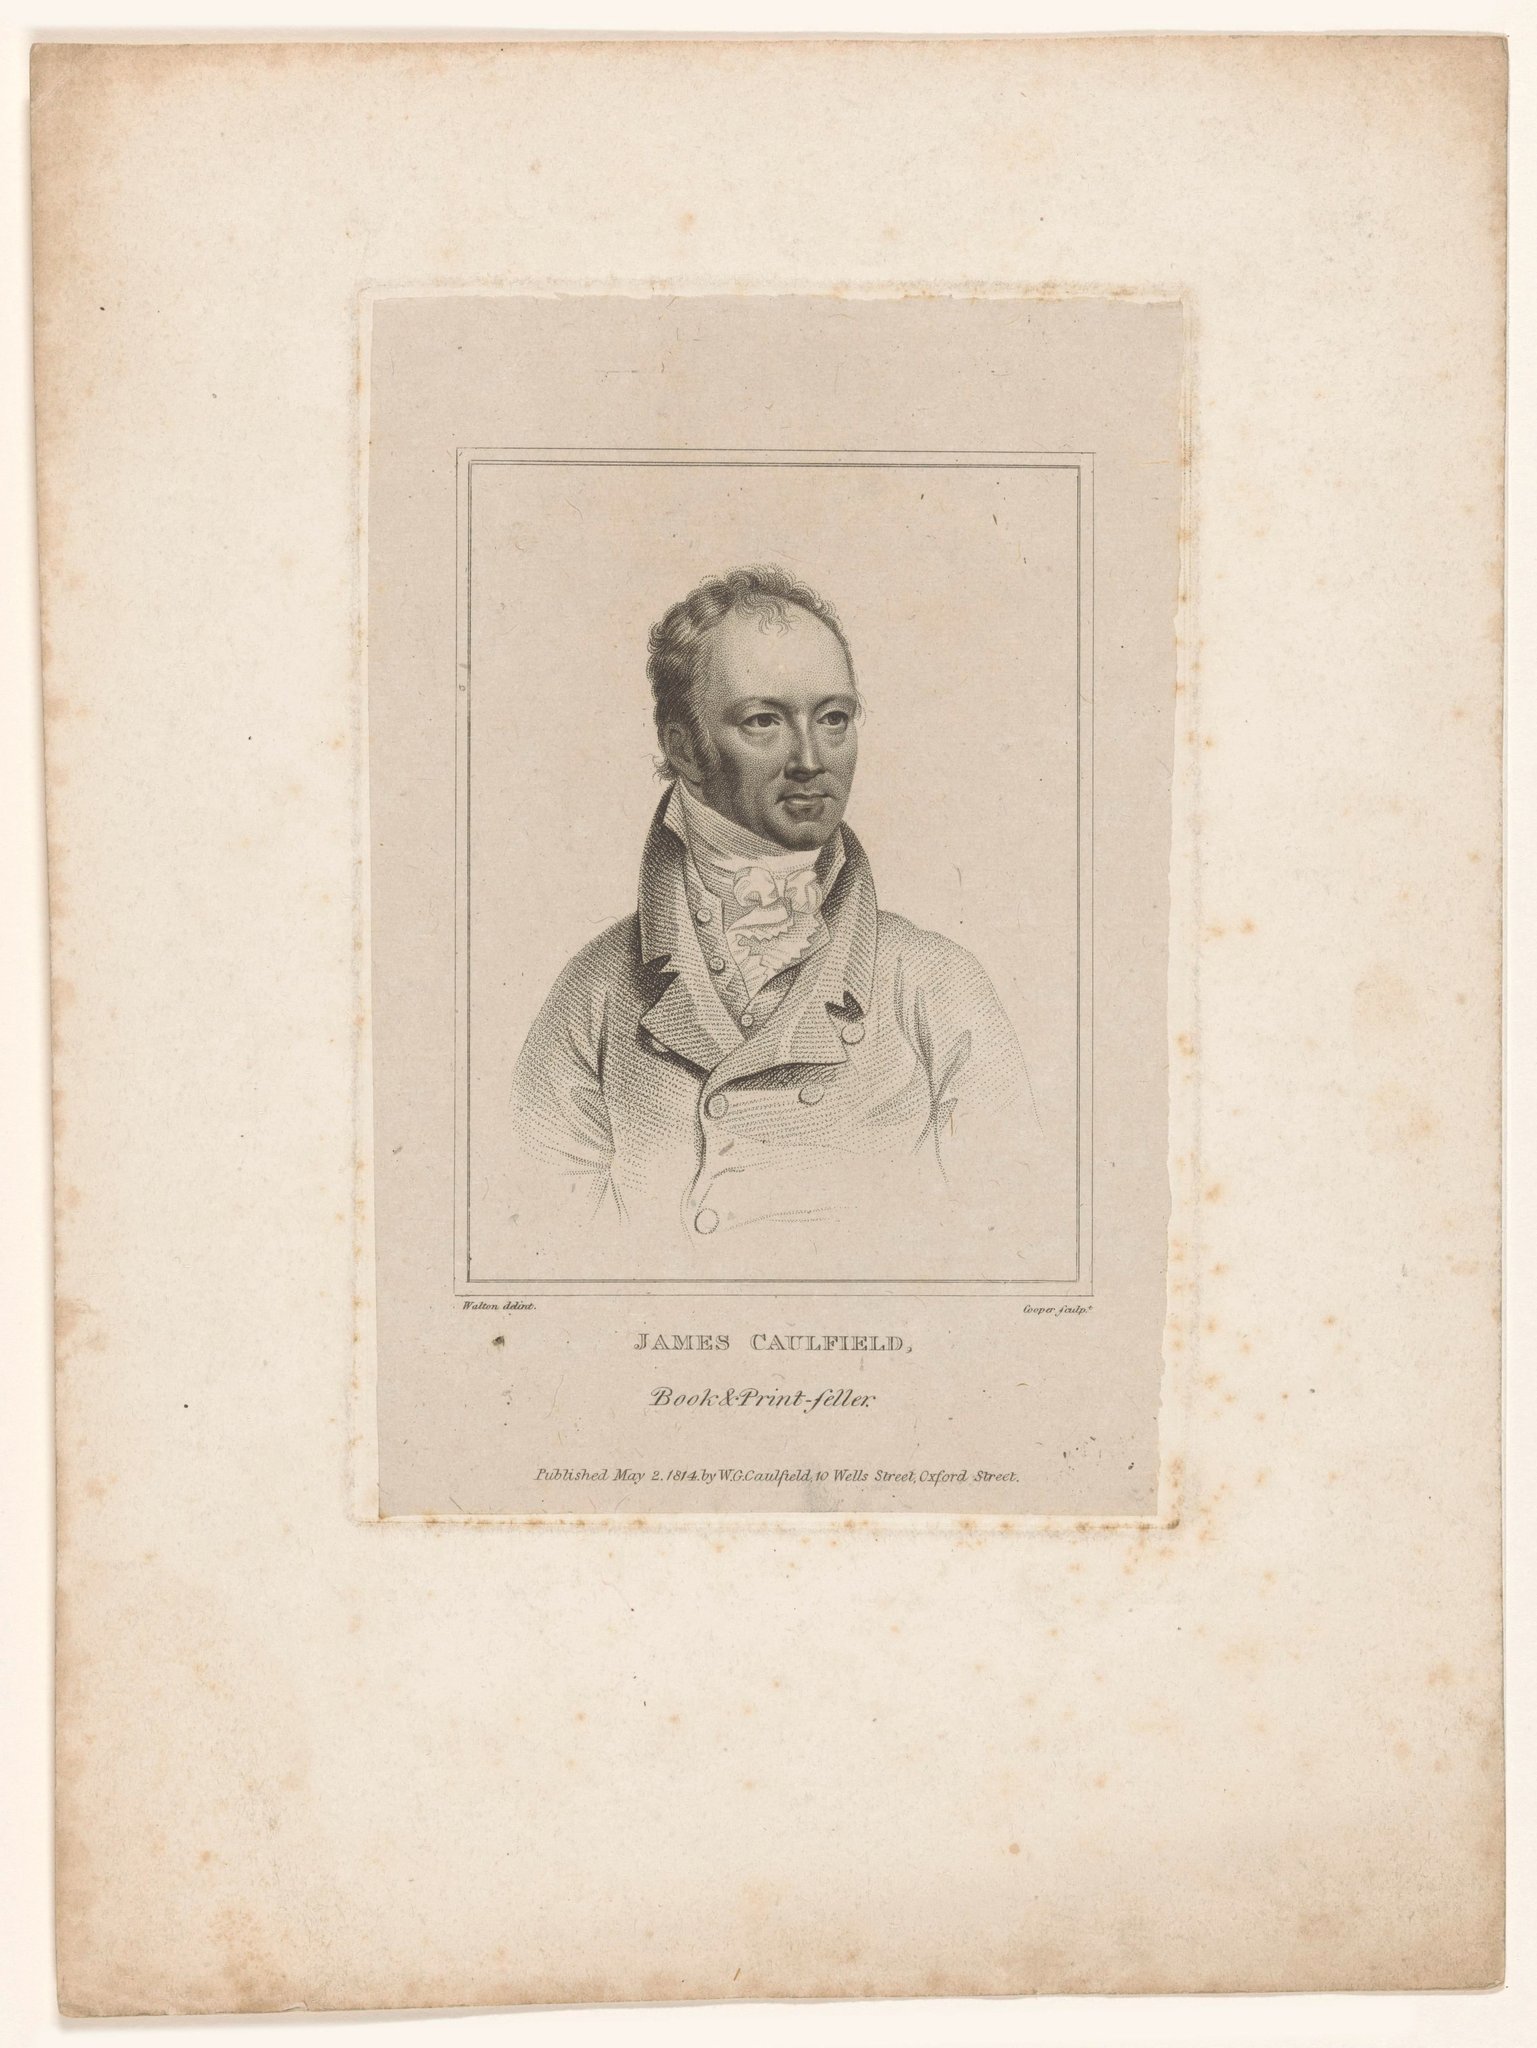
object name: print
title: James Caulfield, Book & Print-seller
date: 1805-1814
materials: paper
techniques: etching, roulette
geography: london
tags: london, art dealer (+ graphic arts), book-shop, bookseller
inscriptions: collector's mark: Lugt 2228